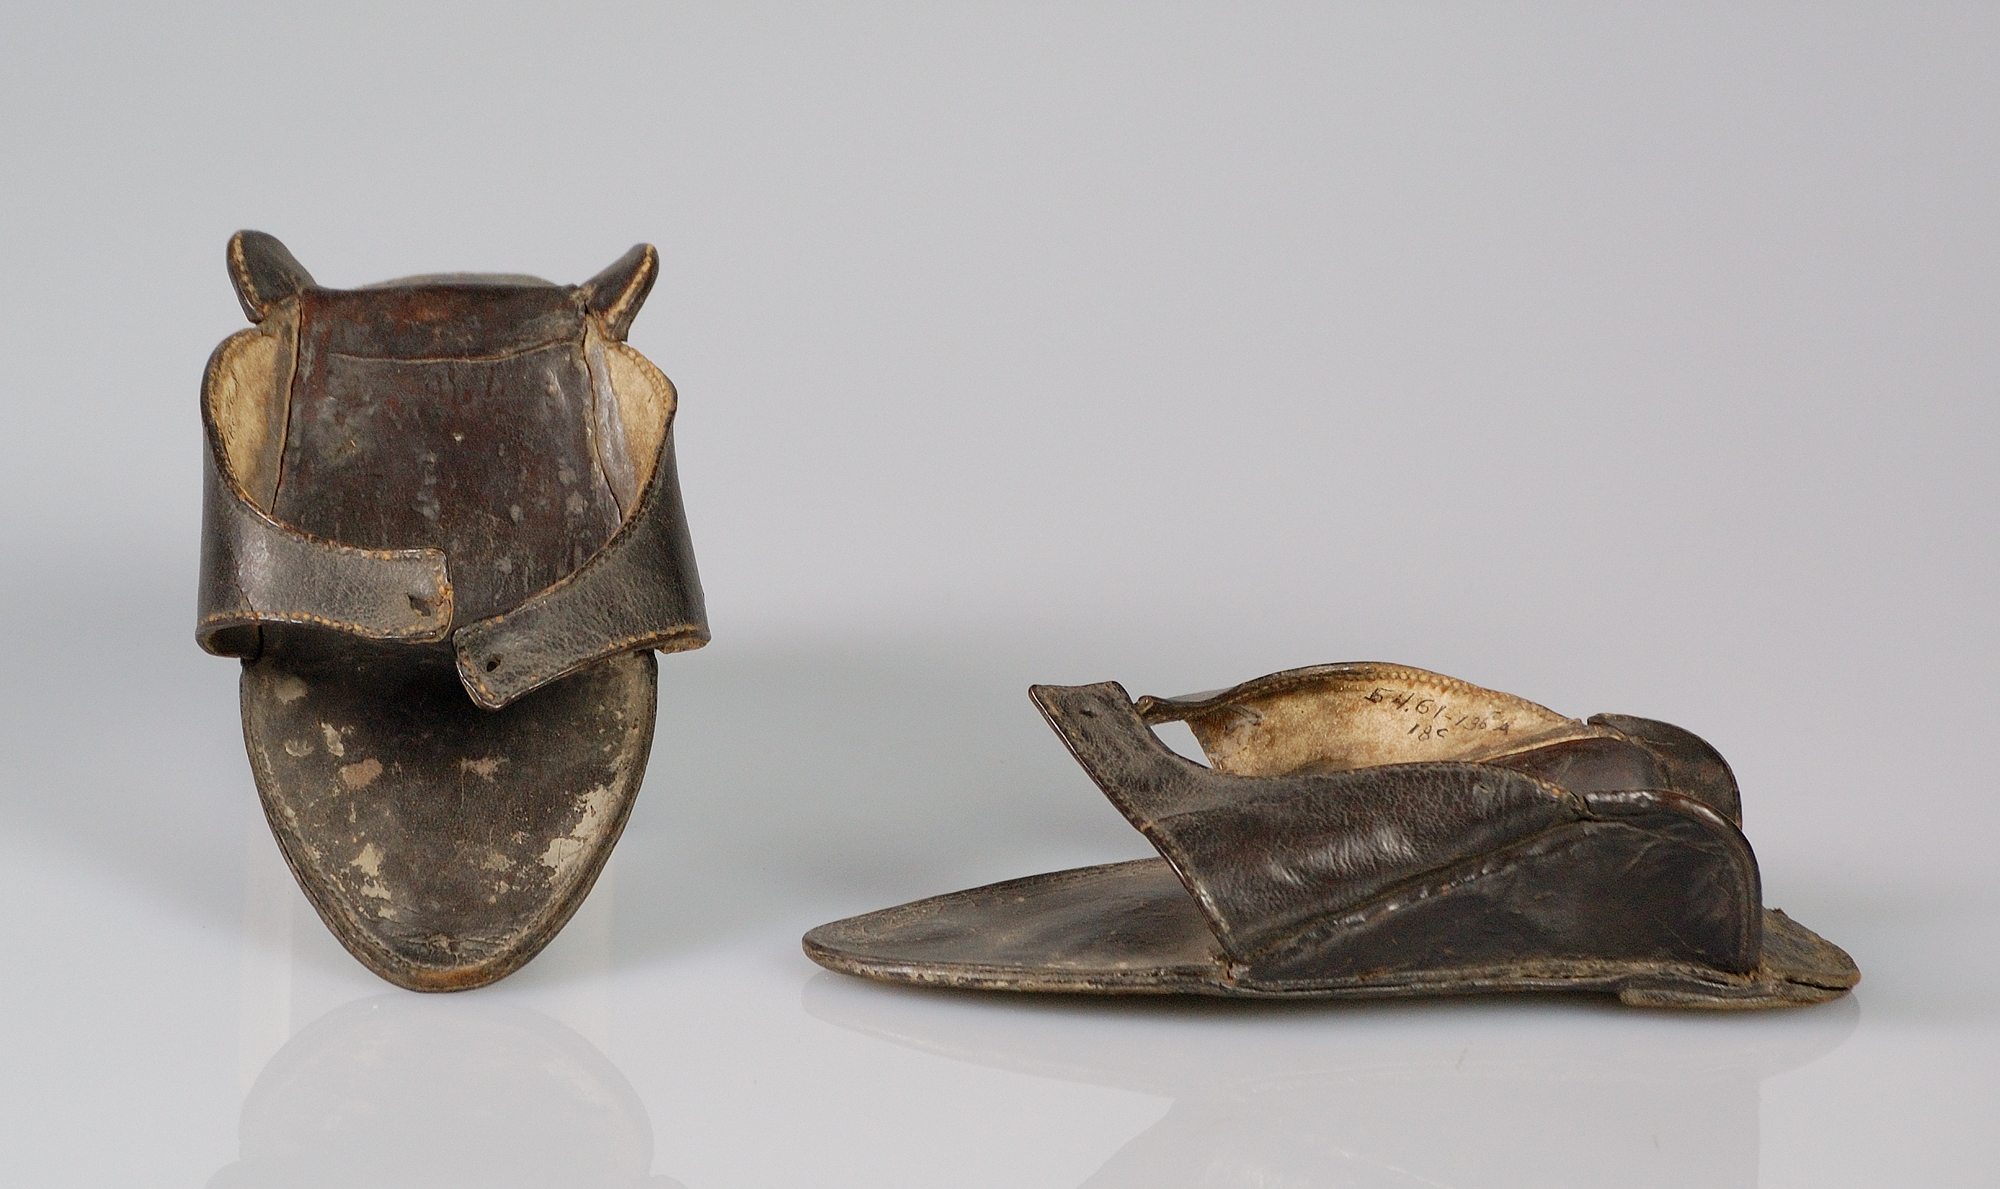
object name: patten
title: Pattens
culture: european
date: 1750-1789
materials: leather